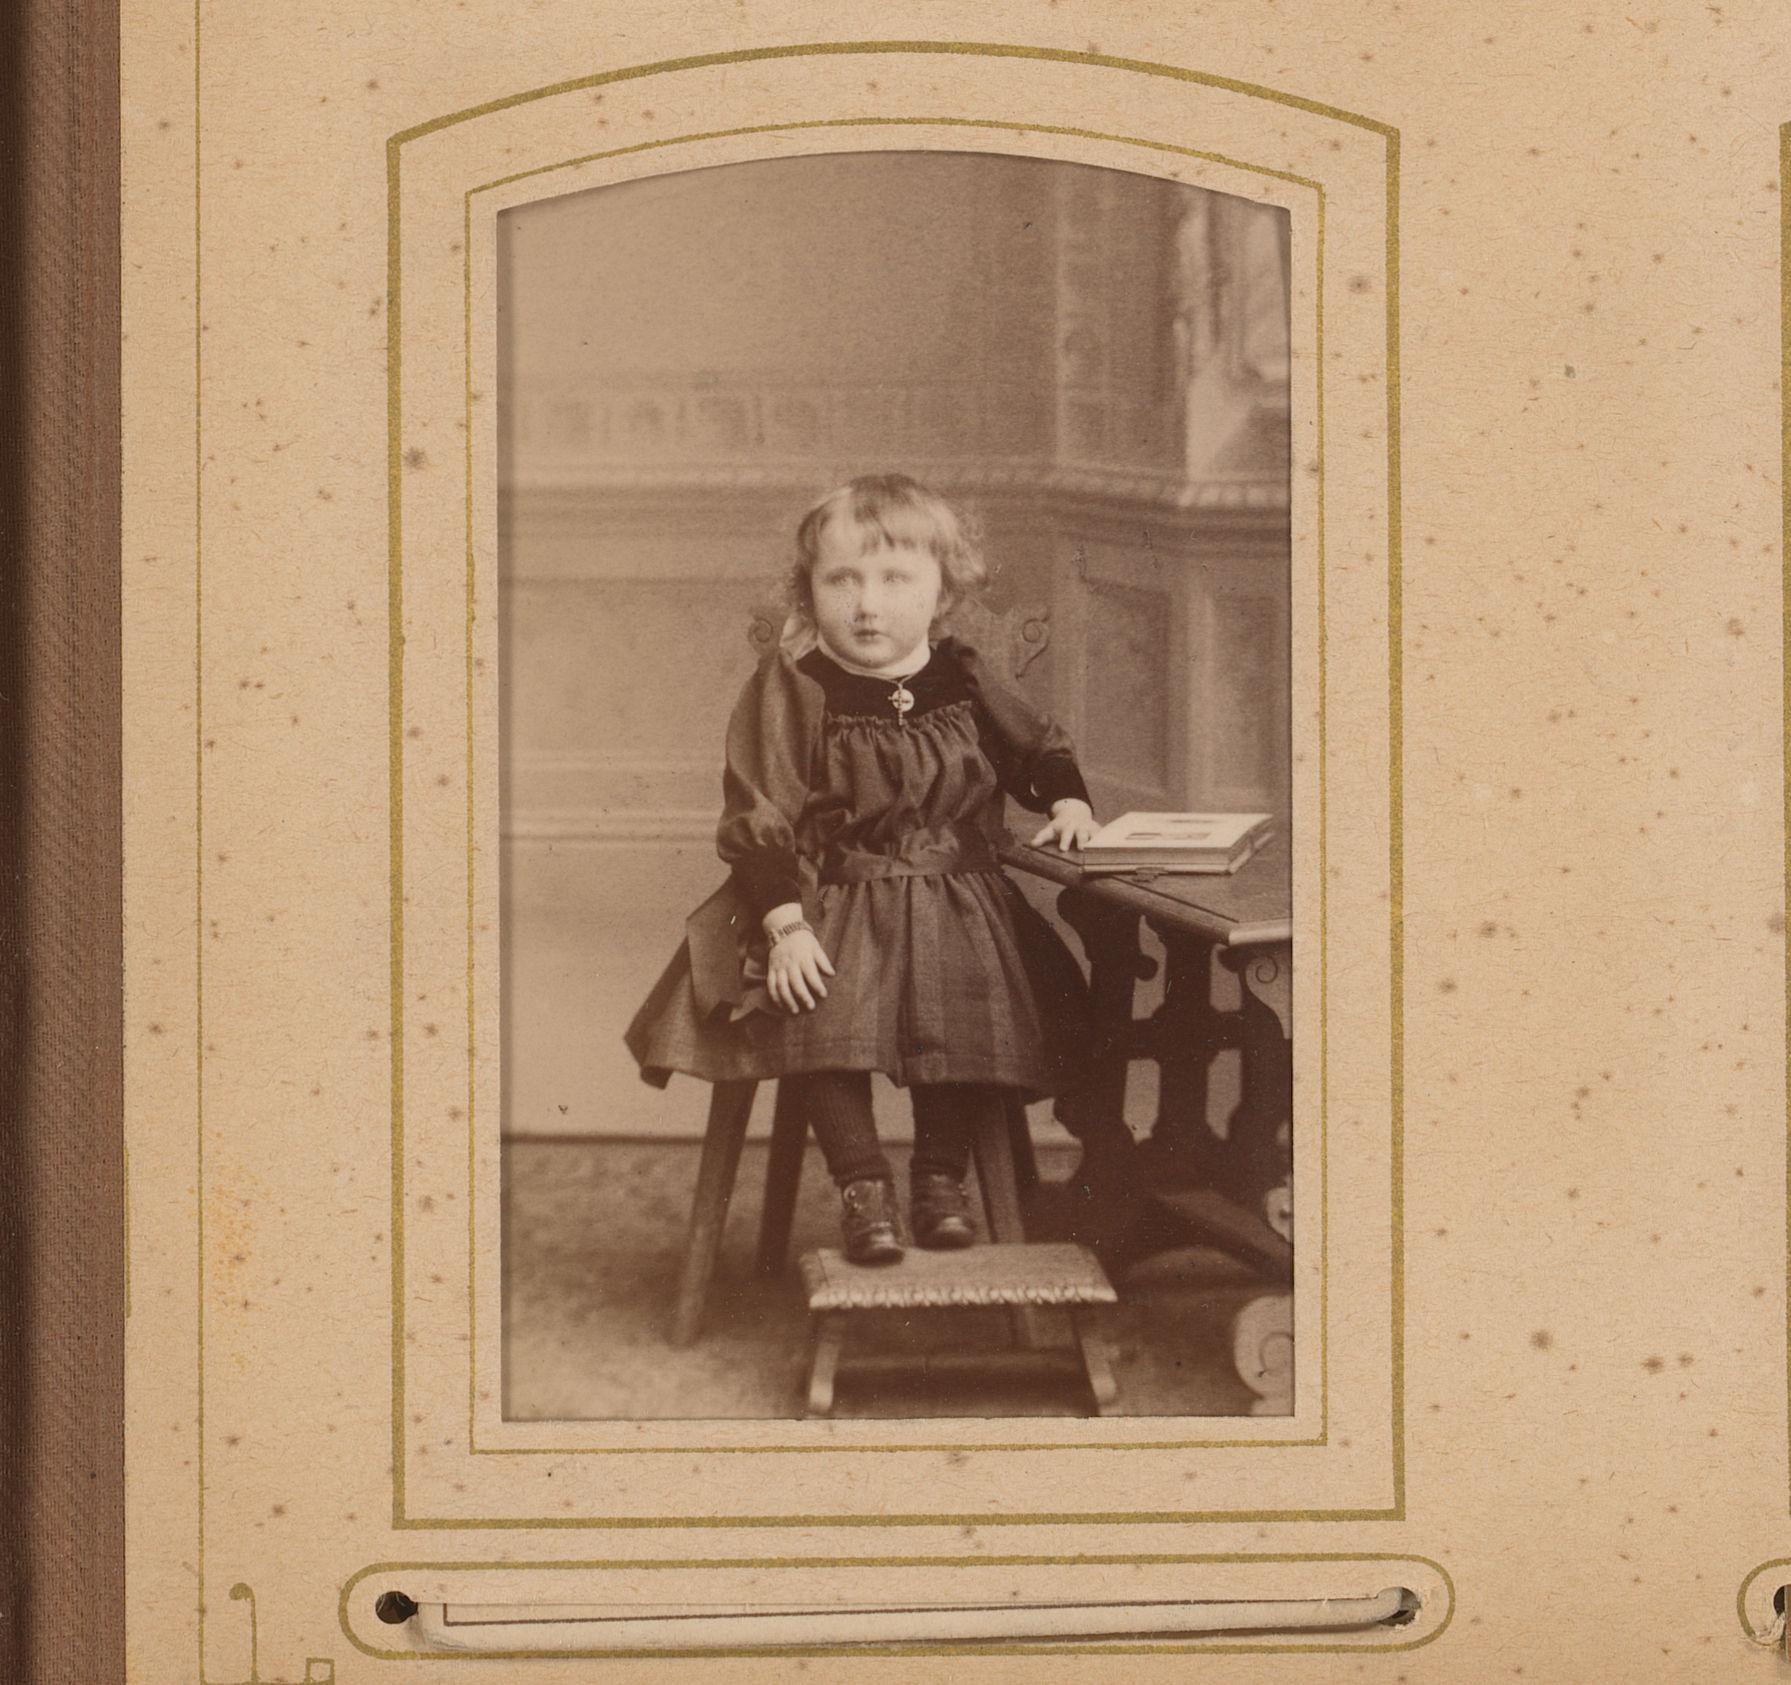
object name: carte de visite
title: Portret van een meisje, zittend aan een tafel waarop een opengeslagen boek ligt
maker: oswald lonke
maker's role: fotograaf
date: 1860-1900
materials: cardboard, photographic support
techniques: albumen print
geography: meissen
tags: sitting figure - aa - female human figure, historical persons - bb - woman, book - mm - book open, table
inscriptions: inscription: ‘Oswald Lonke/ Photograph/ Meissen.’, date: ‘1872’